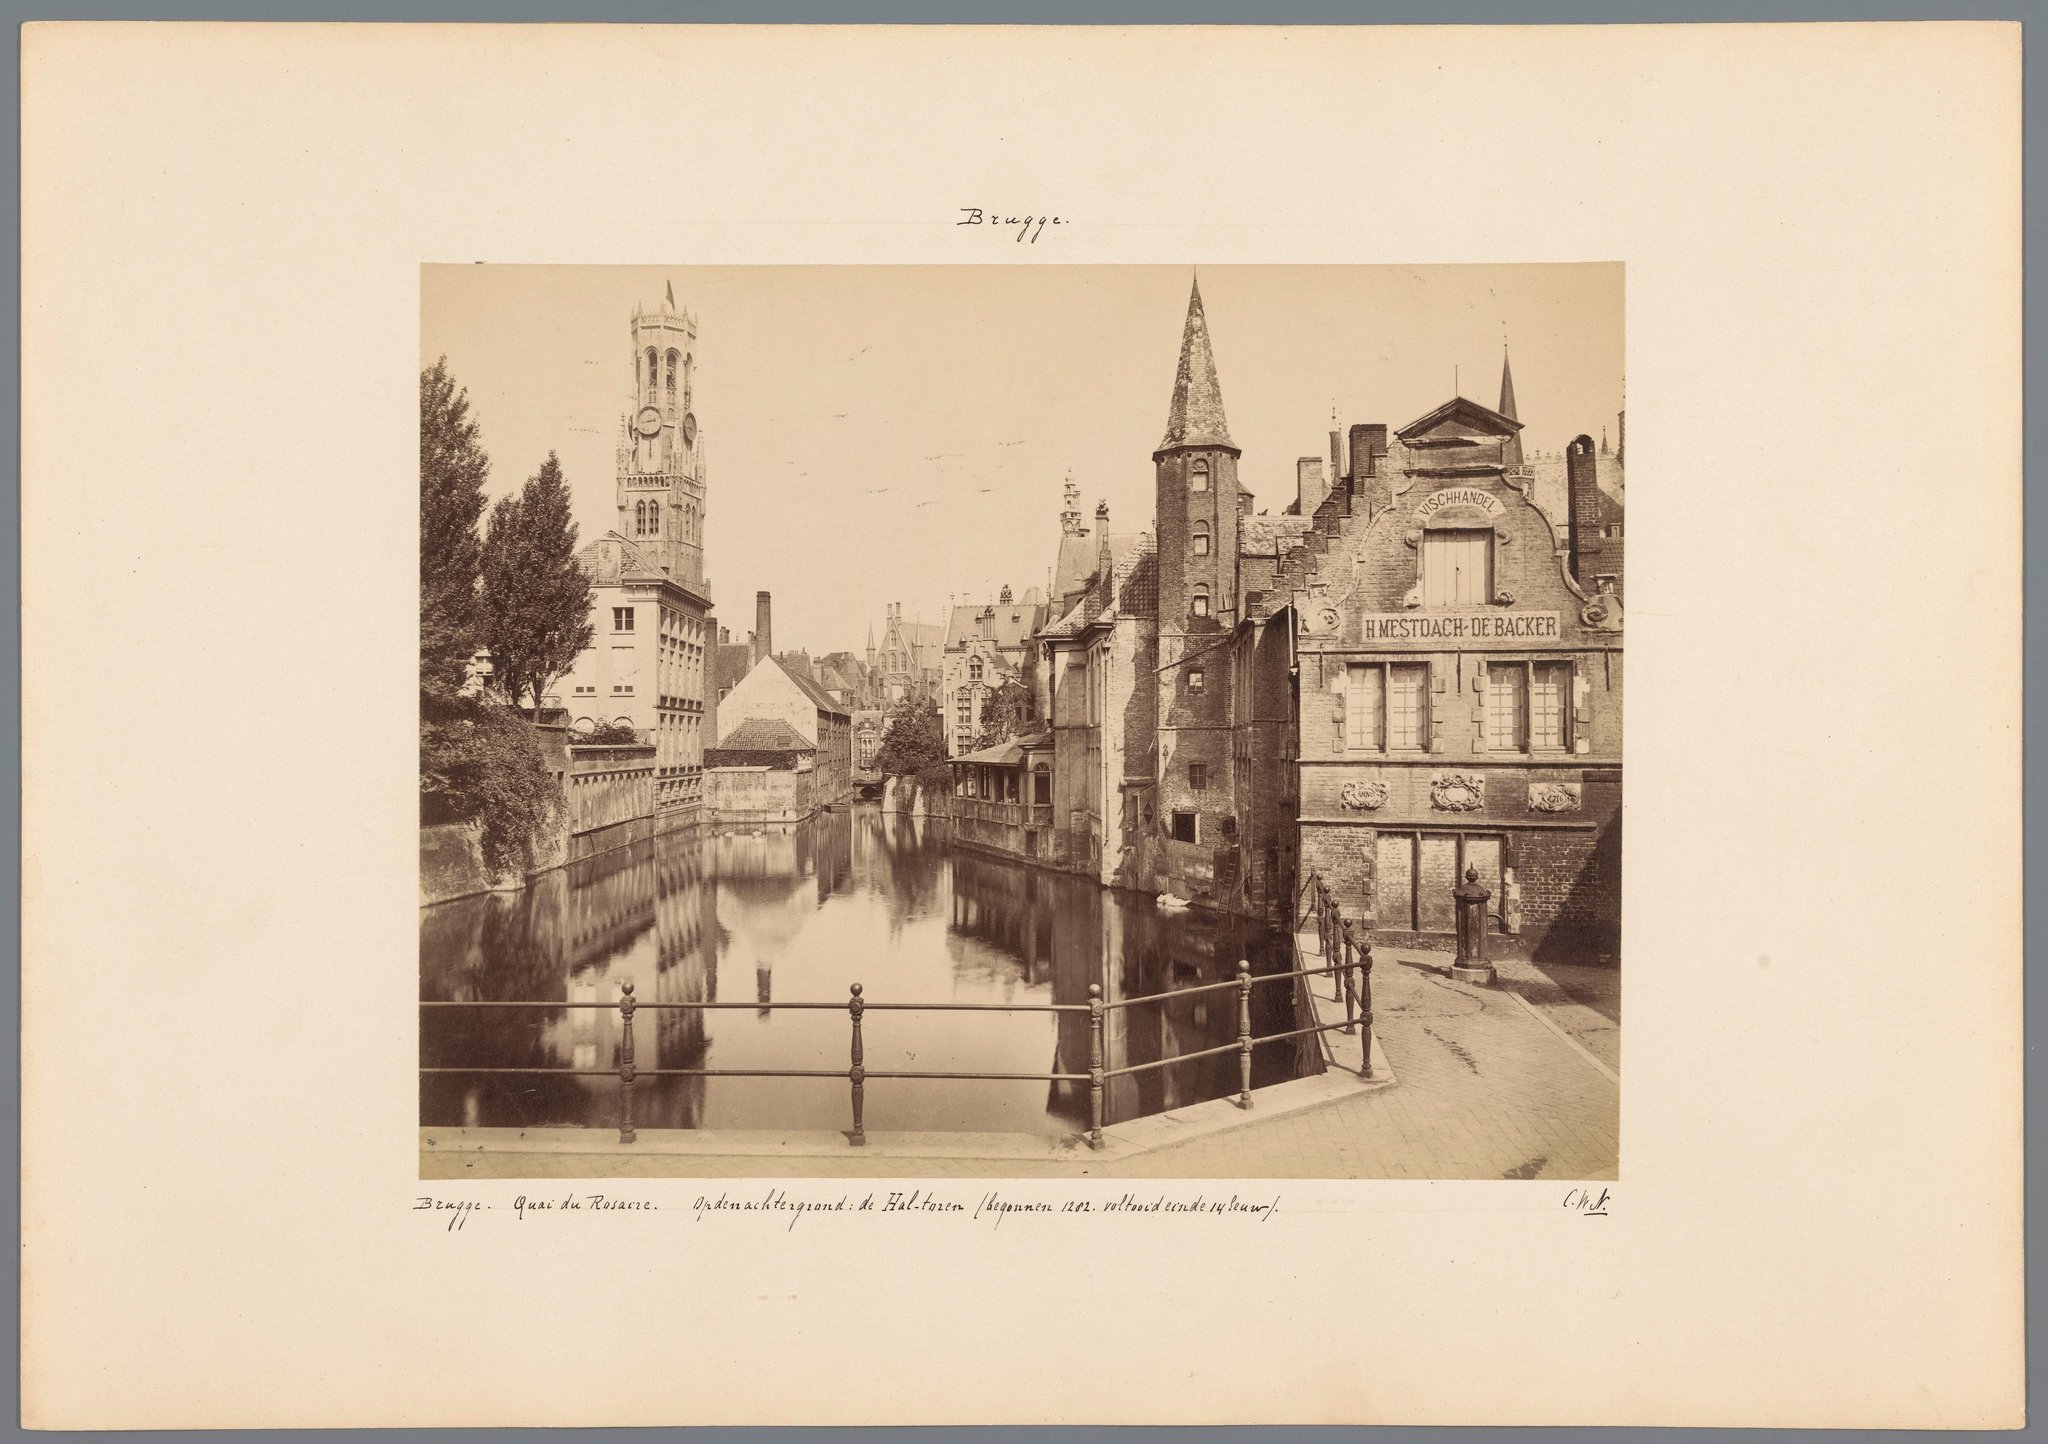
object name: photograph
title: Gebouwen langs de Dijver te Brugge, met op de achtergrond het belfort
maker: Anonymous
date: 1875-1900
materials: cardboard, photographic support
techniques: albumen print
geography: bruges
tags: tower, clock tower ~ monumental adornment, city-view in general; 'veduta', river, façade (of house or building), bruges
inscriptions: inscription: ‘Brugge. Brugge. Quai du Rosaire. Op den achtergrond: de Hal-toren (begonnen 1282. voltooid einde 14 eeuw).’, collector's mark: ‘INSTITUUT VOOR KUNST- NIJVERHEIDSONDERWIJS GABRIËL METSUSTRAAT No. 16. AMSTERDAM’, collector's mark: ‘KUNSTNIJVERHEIDSCHOOL QUELLINUS AMSTERDAM FRANS HALSSTRAAT 14.’, name: ‘C.WN.’